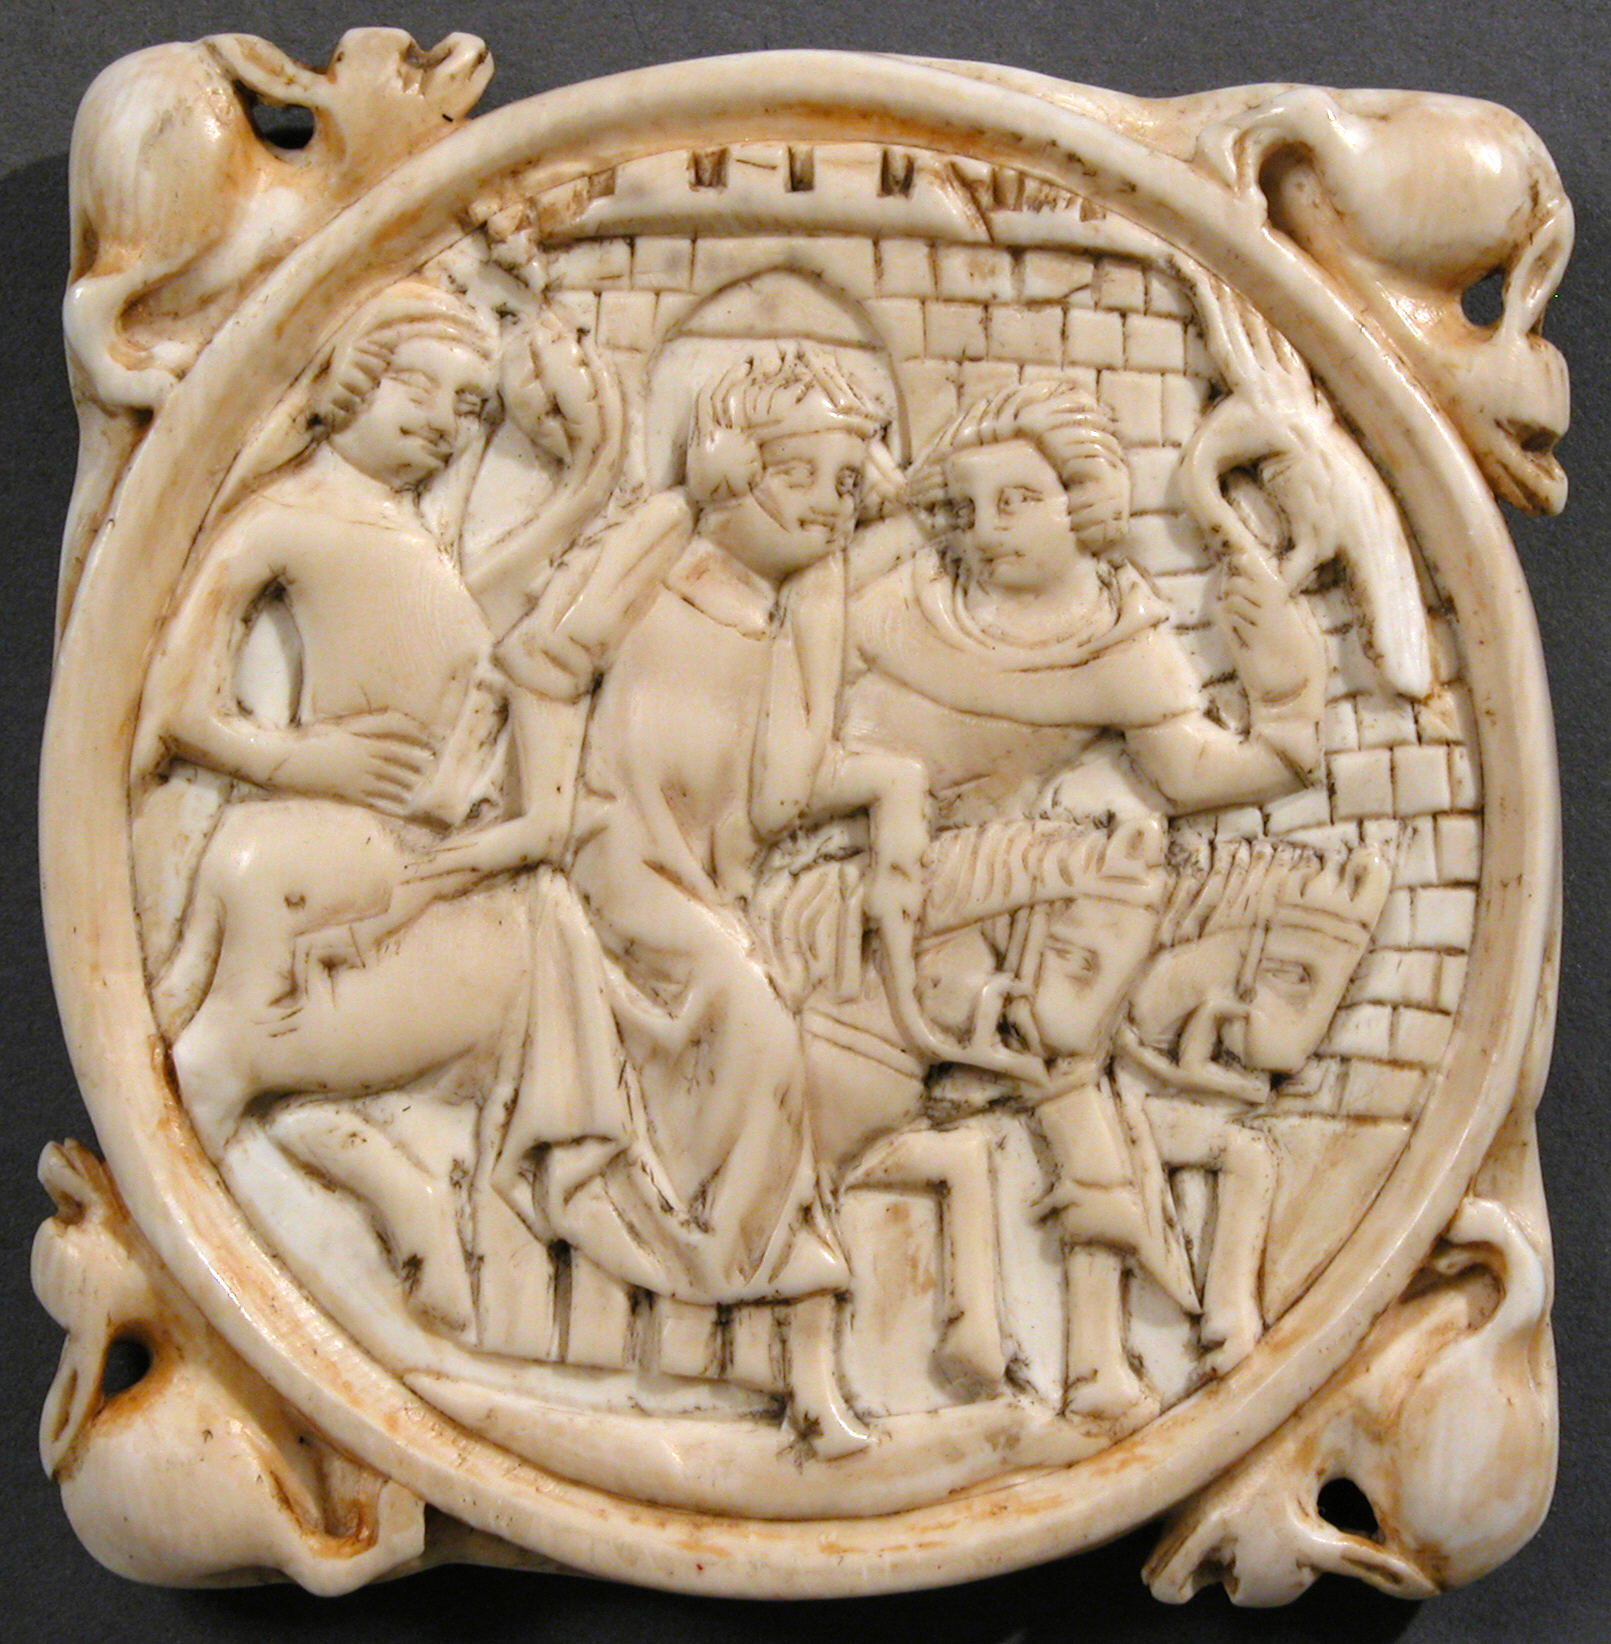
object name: mirror case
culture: french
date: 1350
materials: ivory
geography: france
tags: animals,men,horses